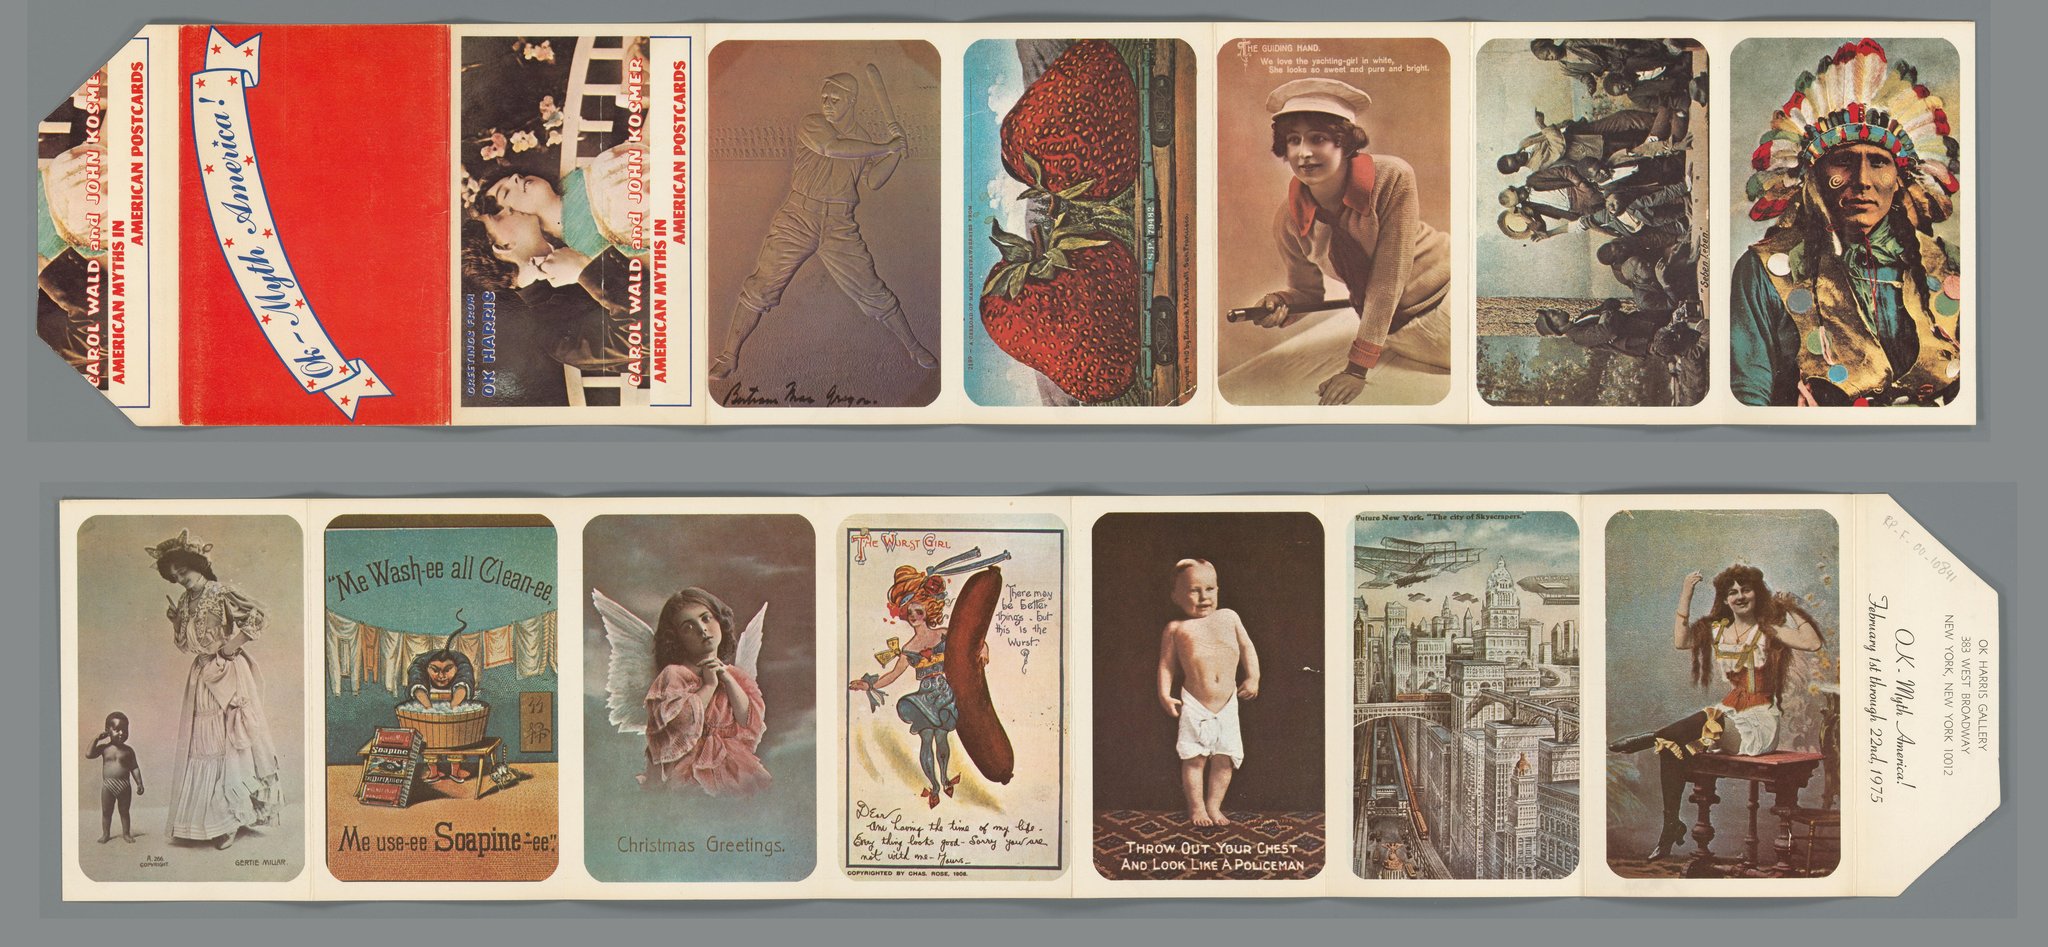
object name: photomechanical print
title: American Myths in American Postcards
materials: paper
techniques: offset printed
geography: new york city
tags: art, united states of america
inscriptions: : ‘.’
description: Leporelloalbum met dertien fotomechanische afdrukken van 'American Myths', appropriation-kunstwerken van Carol Wald en John Kosmer.